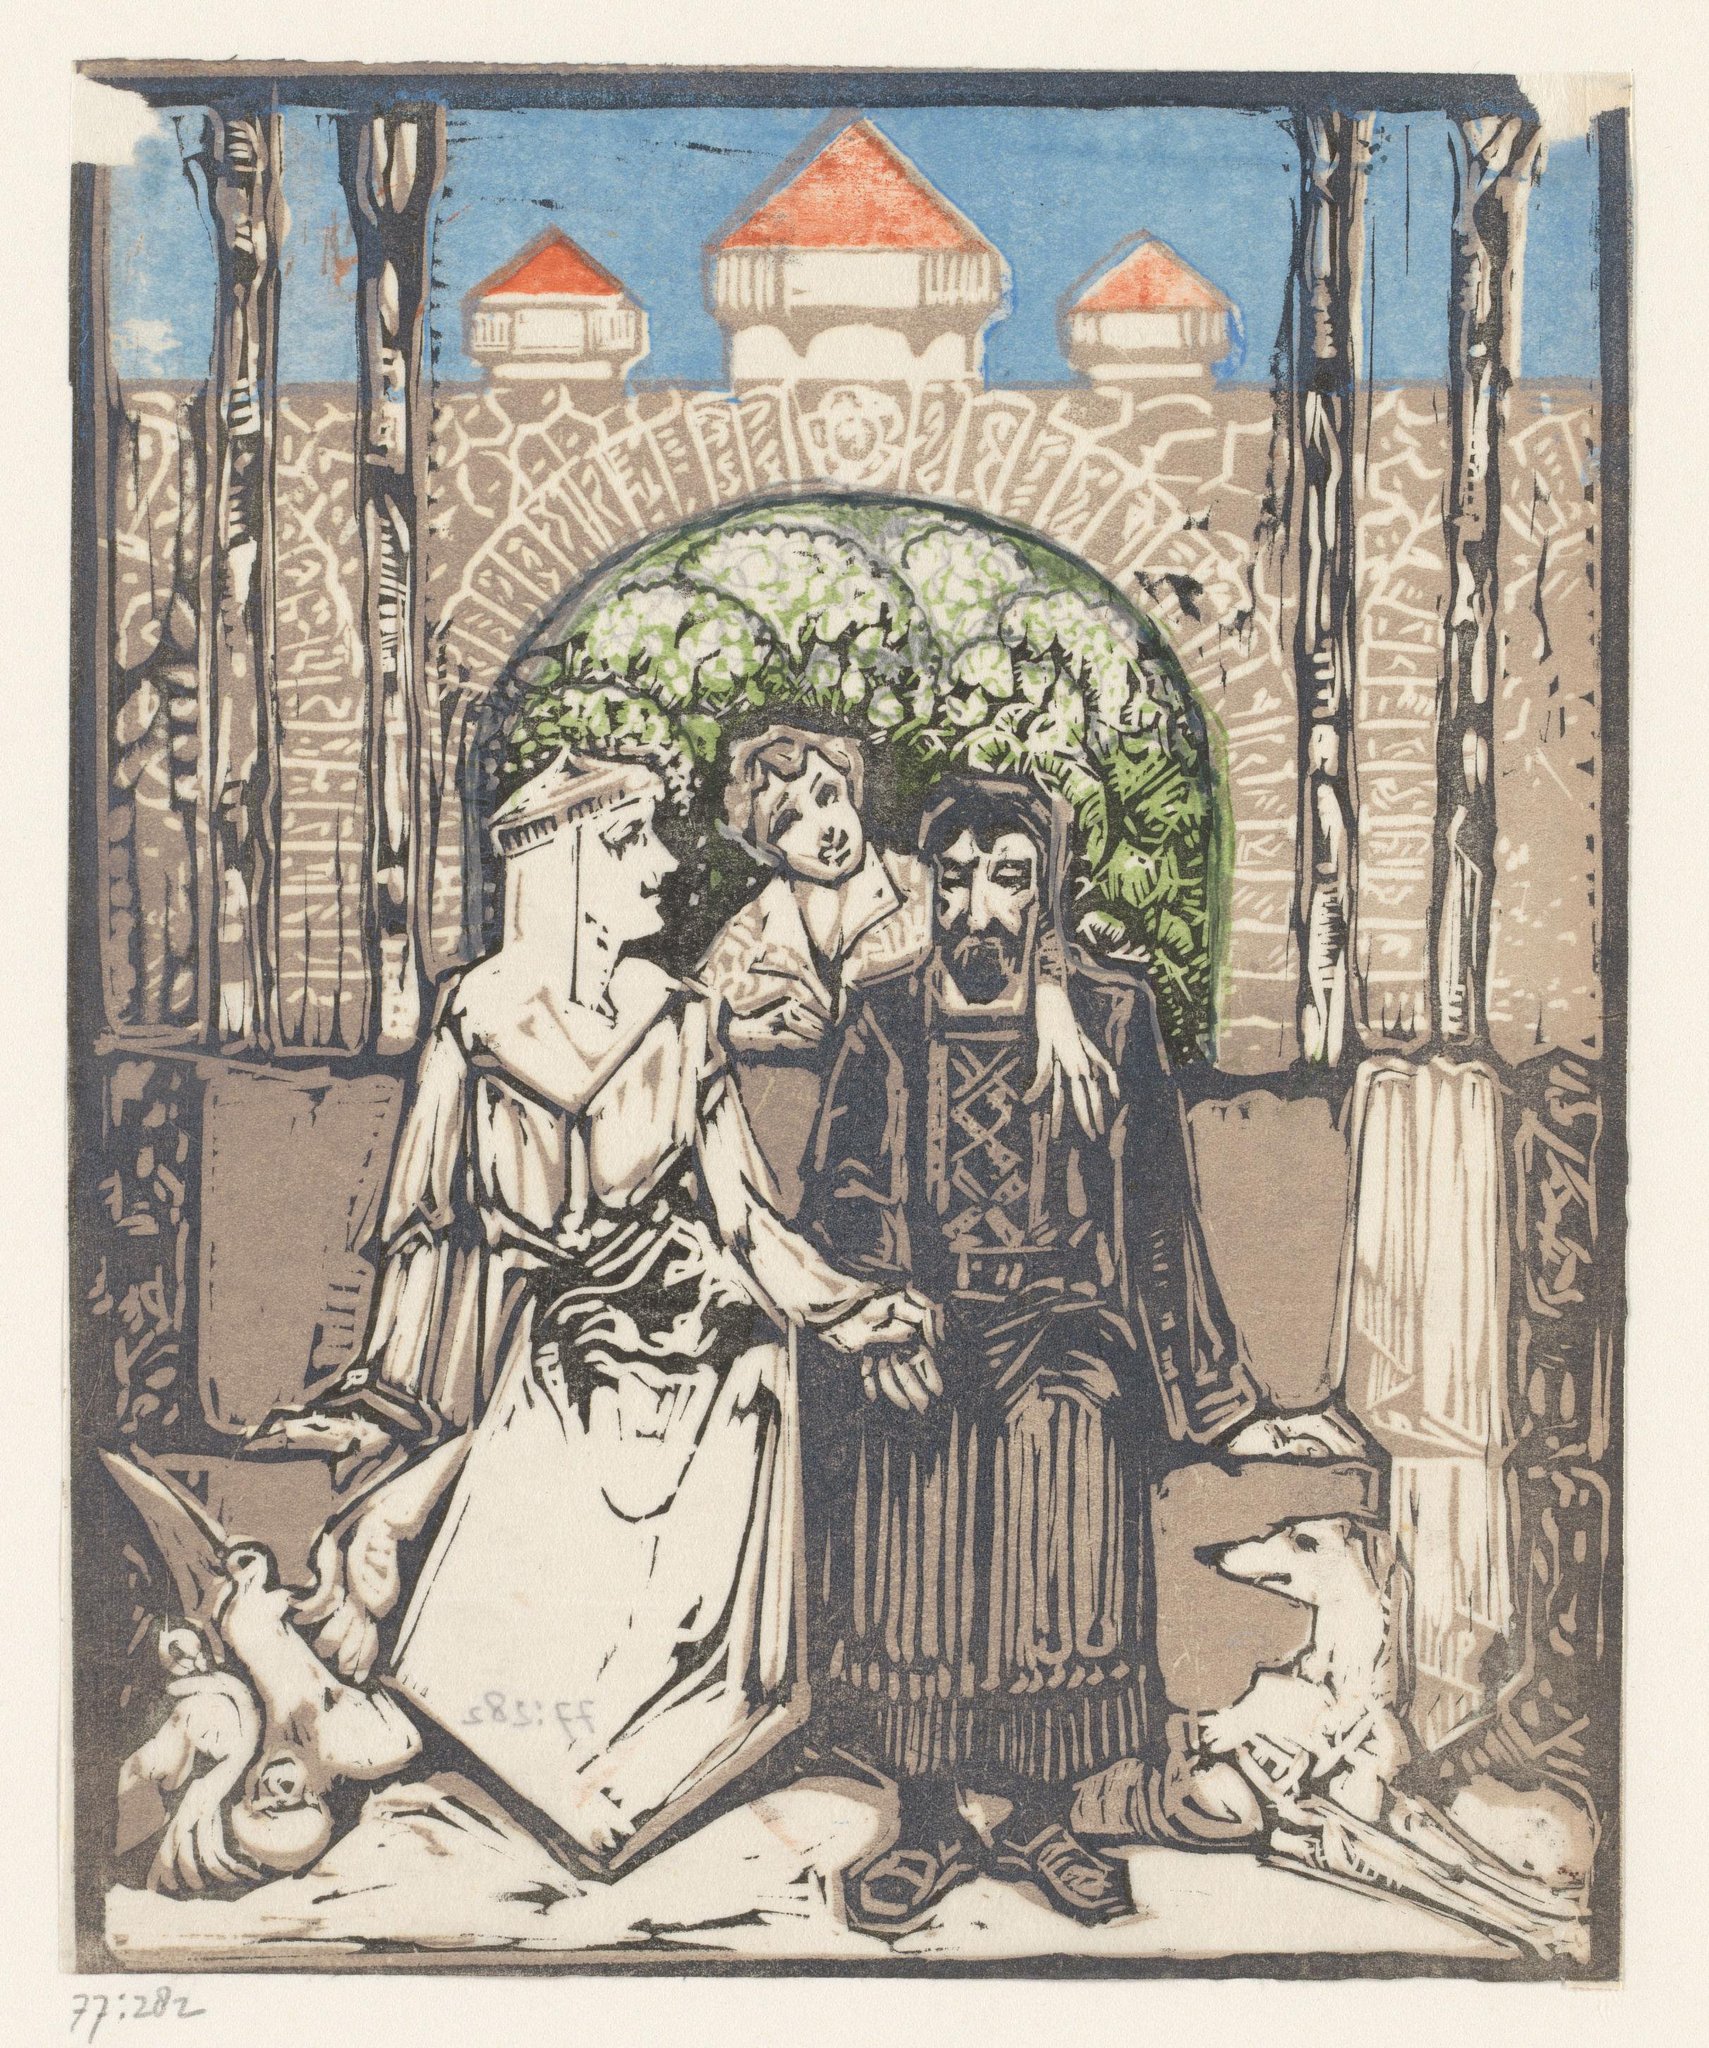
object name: print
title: Zittend paar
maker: bernard willem wierink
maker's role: draughtsman, print maker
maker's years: 1856-1939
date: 1938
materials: paper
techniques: relief print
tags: other birds: dove, couple of lovers, dog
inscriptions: collector's mark: Lugt 2228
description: Illustratie voor een uitgave van een onbekend toneelstuk. Deze prent is waarschijnlijk een plaatsnede, ook al wordt in de literatuur veelal gesproken over een houtsnede. Voor zover Wierink zijn prenten in hoogdruk zelf heeft omschreven, heeft hij altijd de term 'plaatsnede' gebruikt.